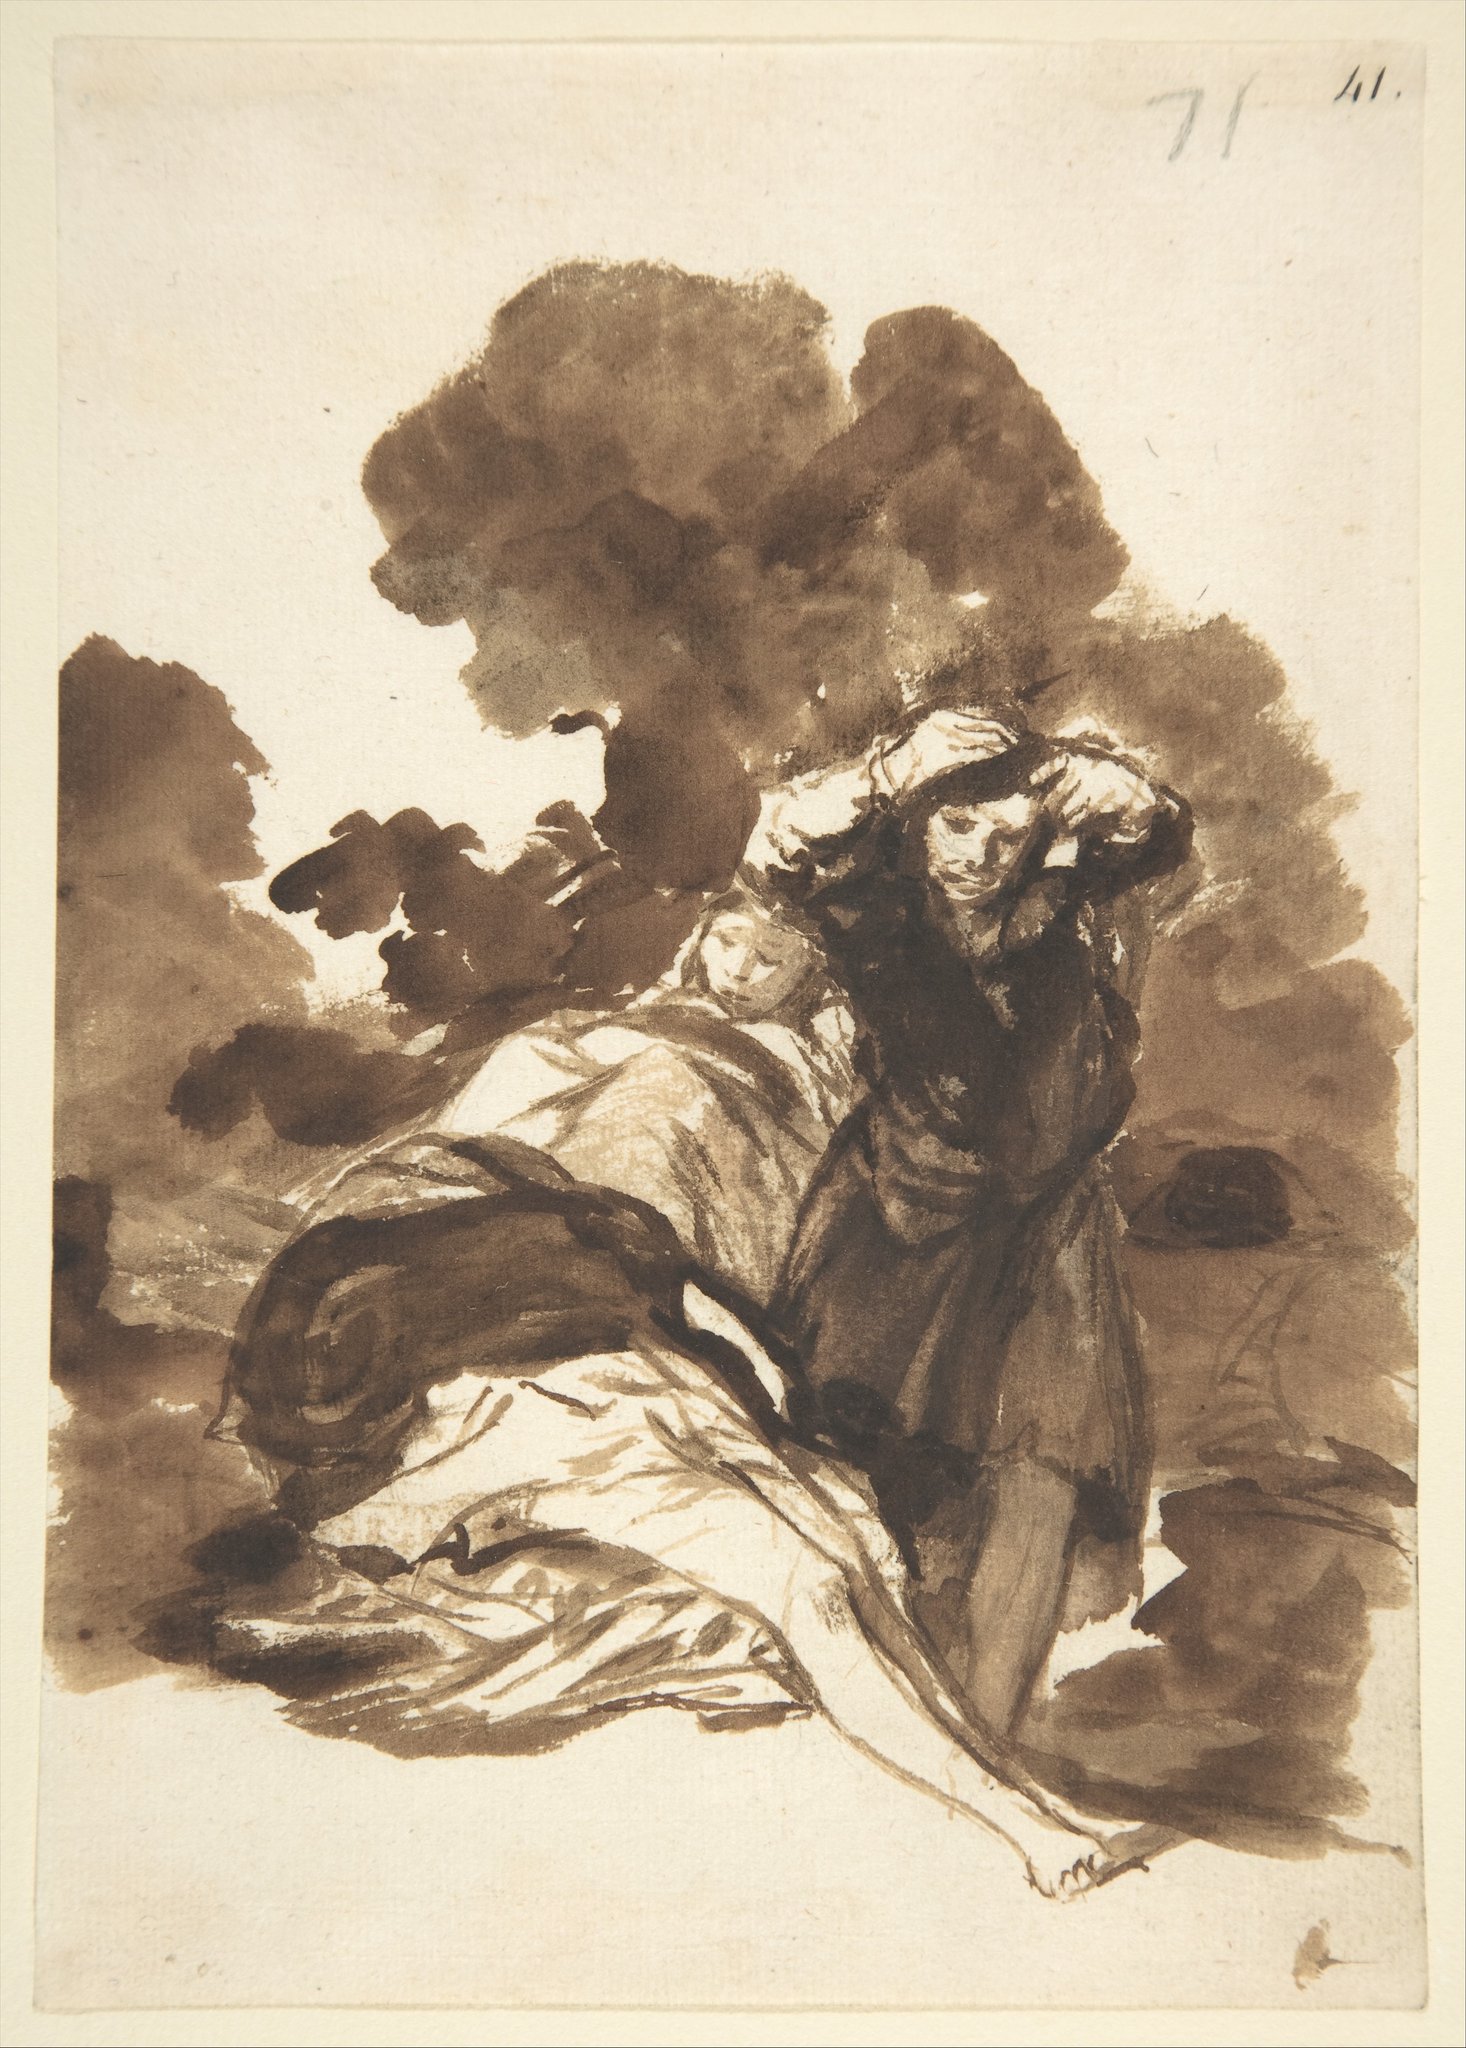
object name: drawing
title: Figures waking from sleep (?); page 71 from the "Images of Spain" Album (F)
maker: goya (francisco de goya y lucientes)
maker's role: artist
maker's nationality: spanish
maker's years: 1746-1828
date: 1812-1820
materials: chalk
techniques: brush, wash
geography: spain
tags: human figures,sleeping,walking